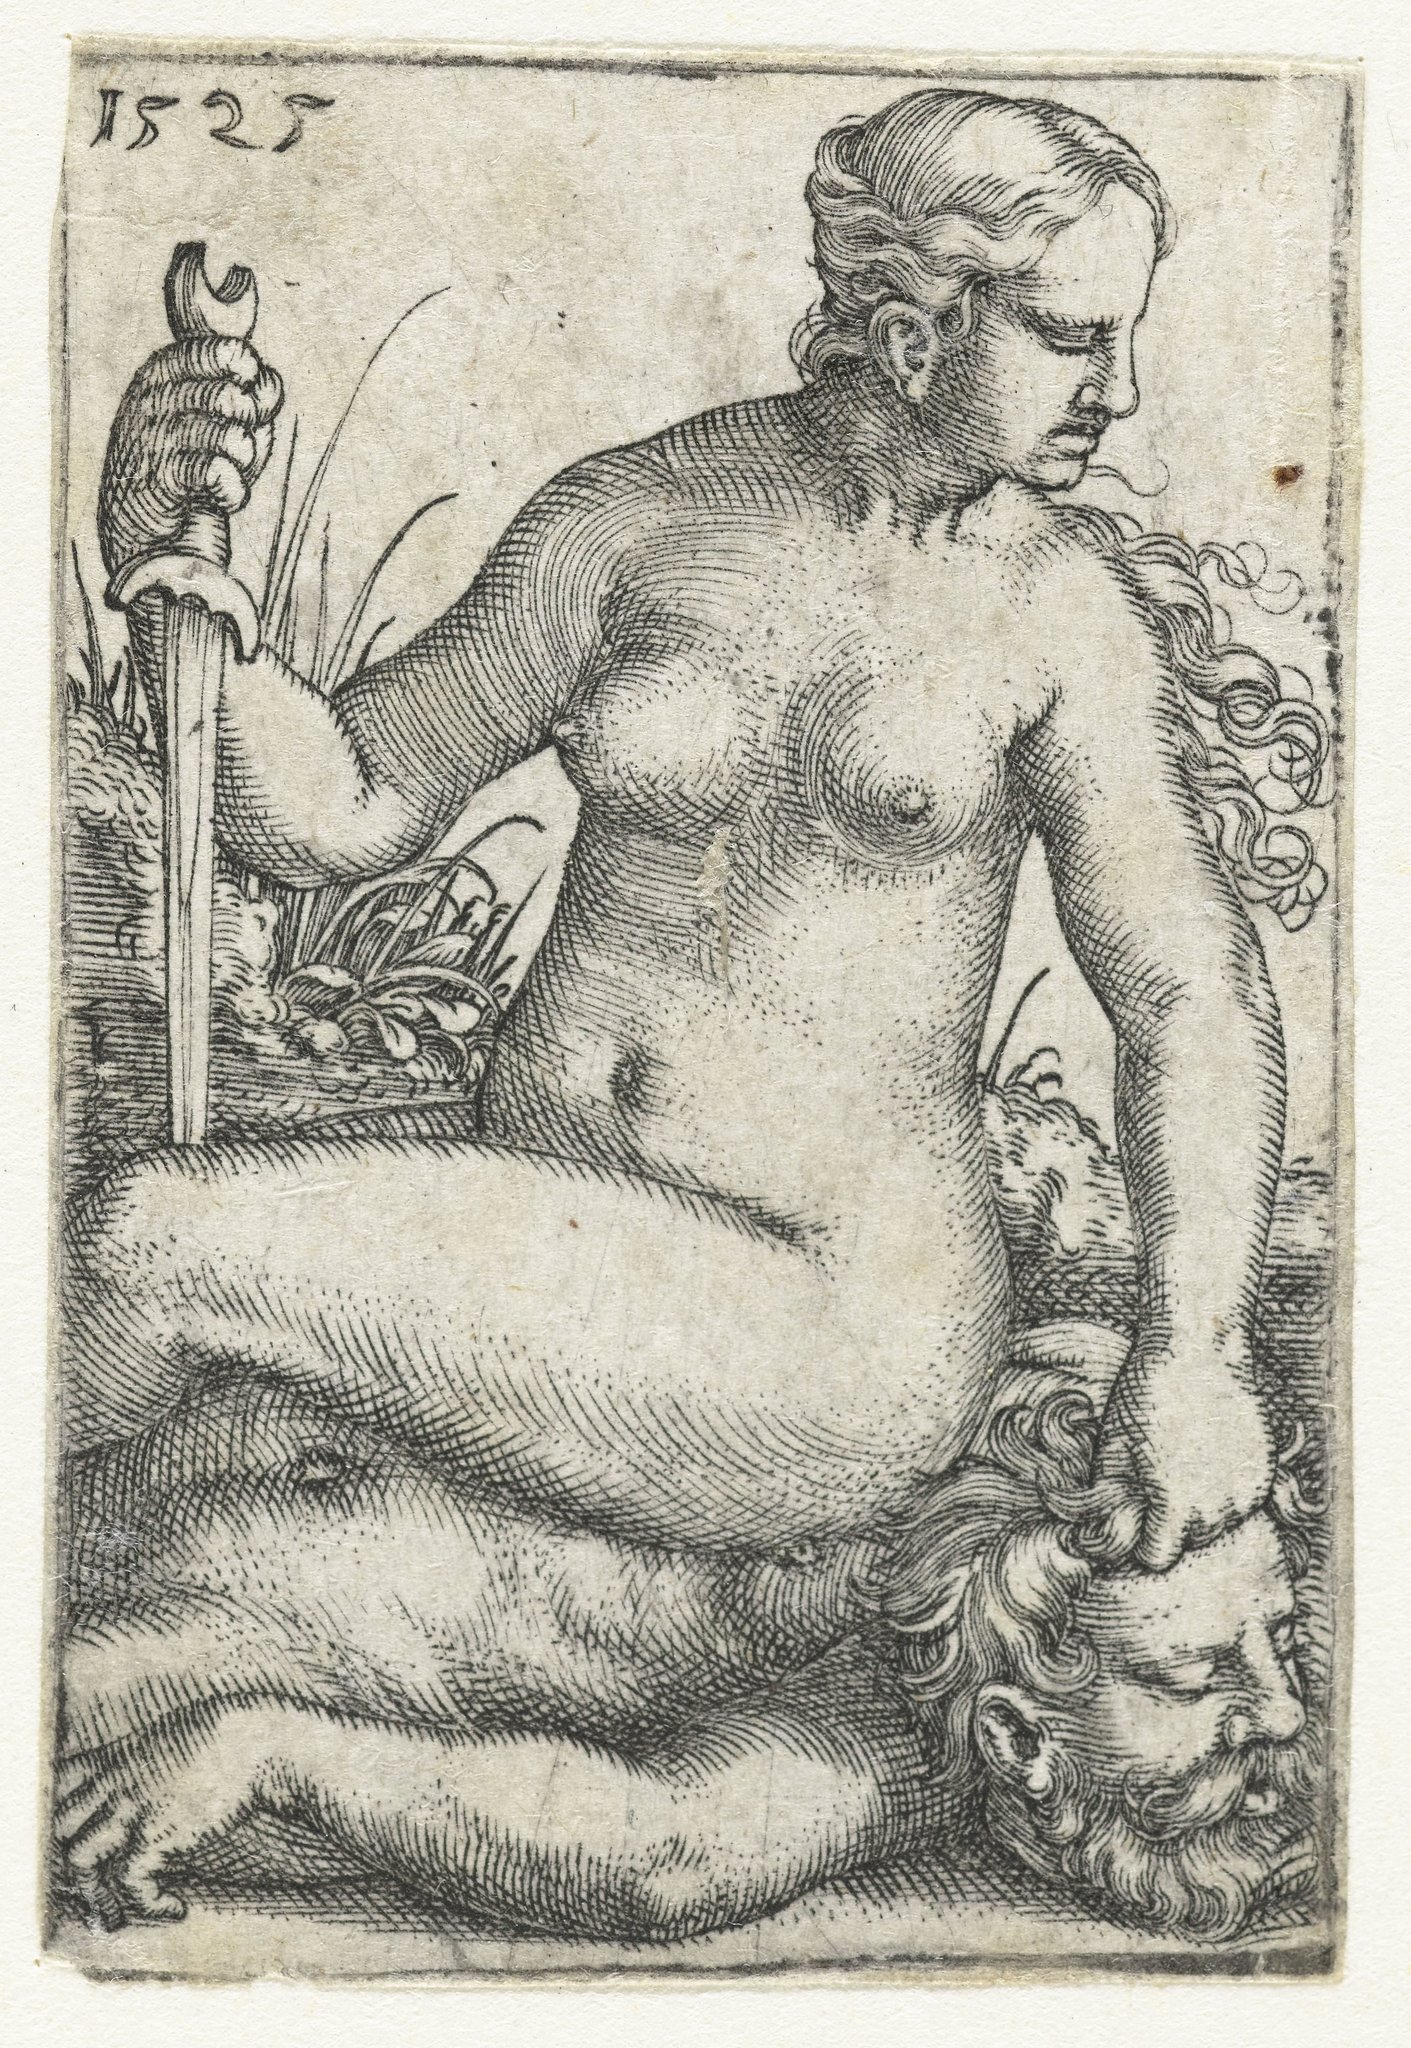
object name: print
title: Judith met zwaard zittend op het onthoofde lichaam van Holofernes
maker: barthel beham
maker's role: print maker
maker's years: 1502-1540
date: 1525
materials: paper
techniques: engraving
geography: nuremberg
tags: judith and holofernes (judith 8-16)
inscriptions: date